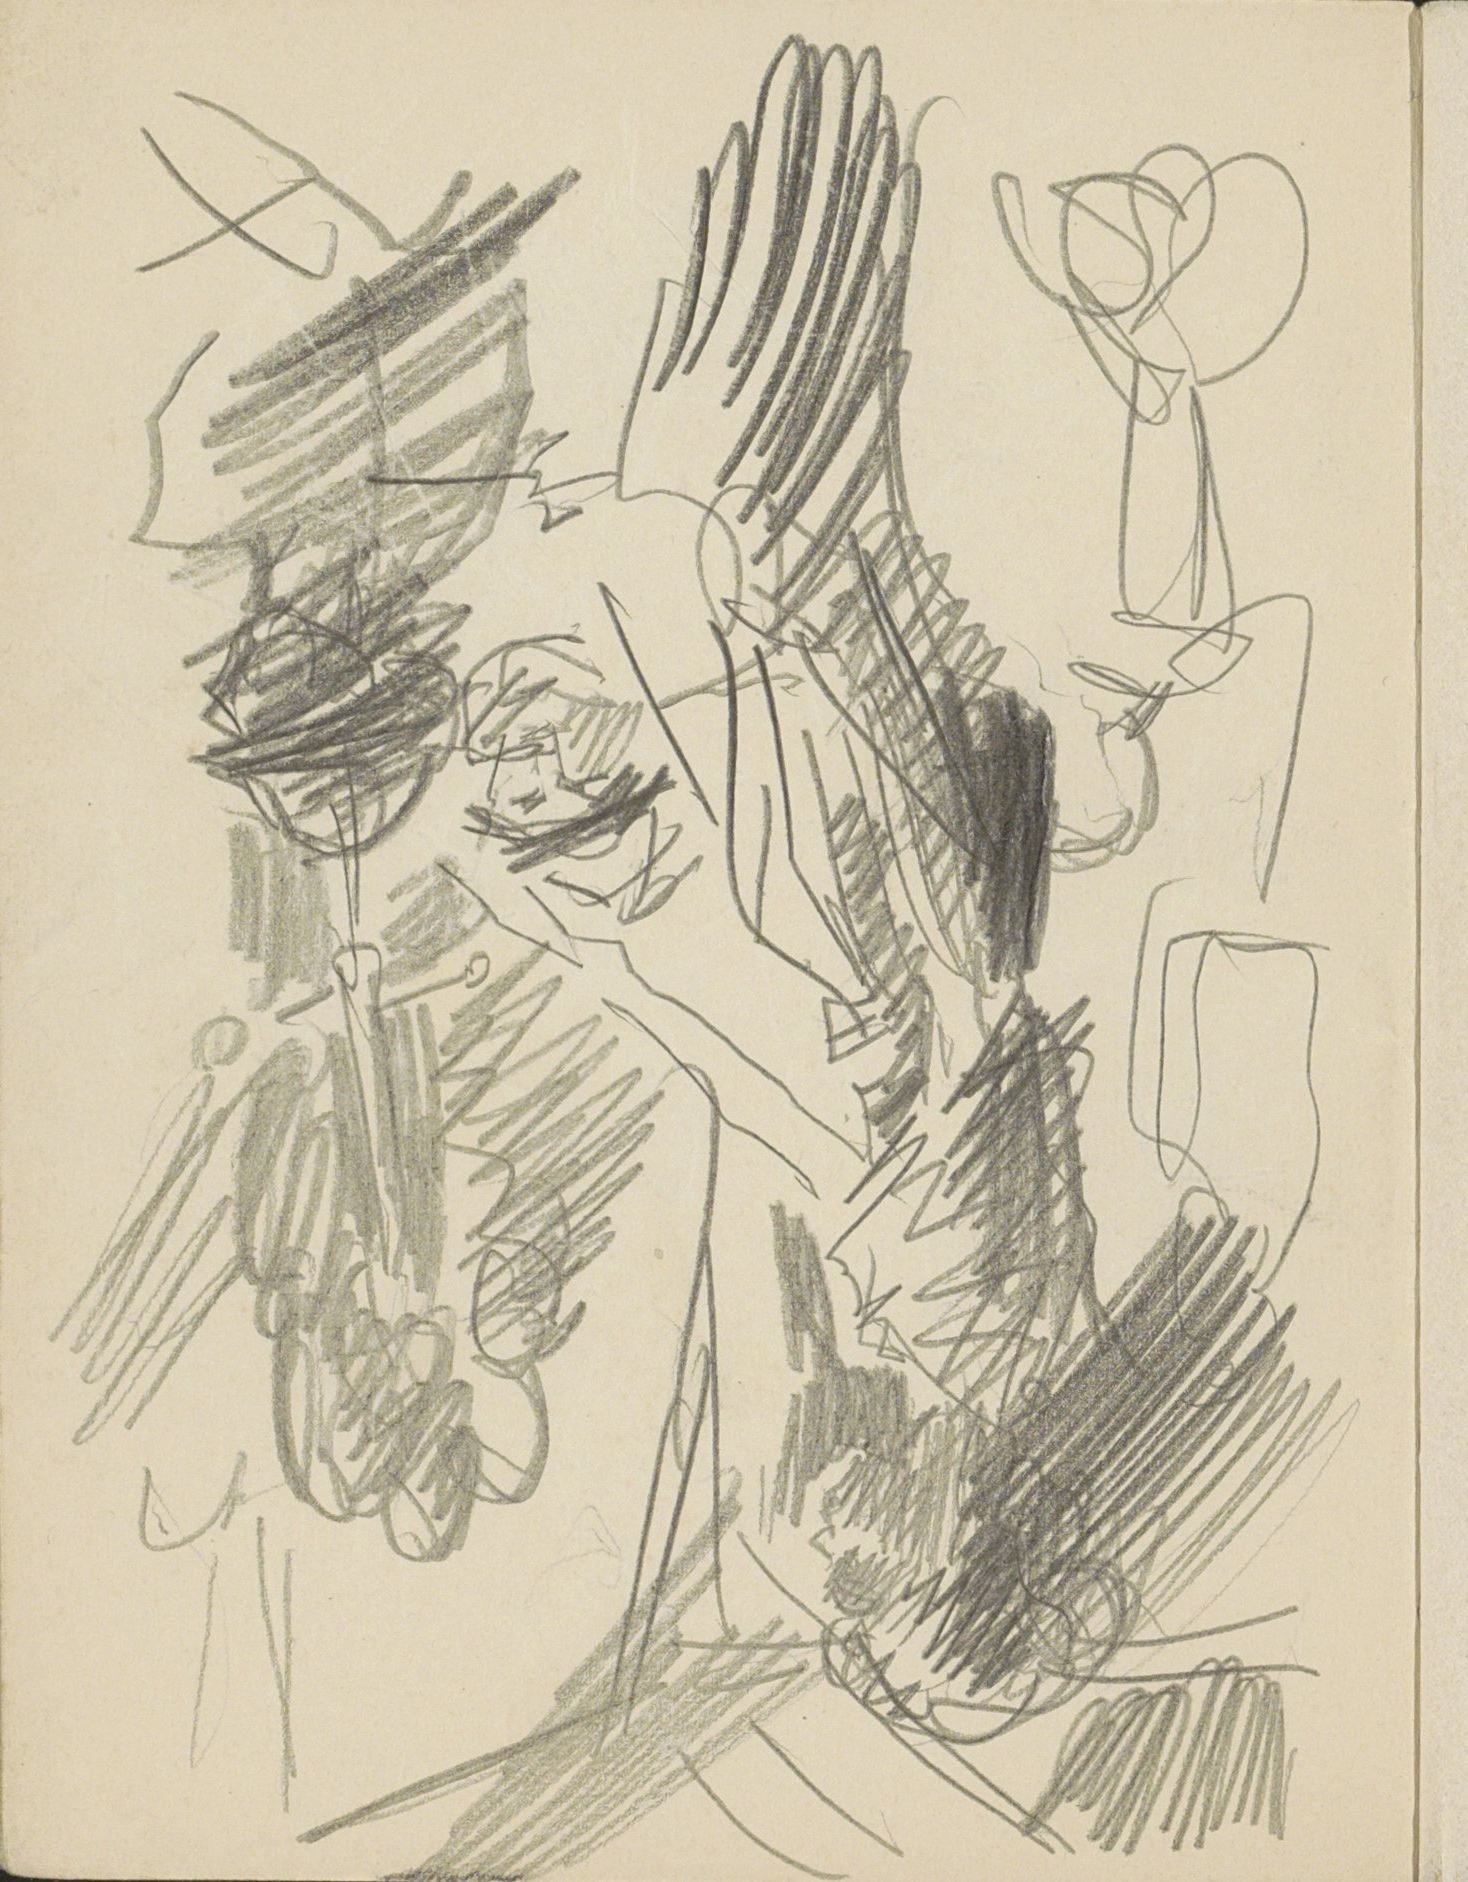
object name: sketchbook leaf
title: Zittende en staande Indische figuren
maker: isaac israels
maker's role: draughtsman, painter, print maker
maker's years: 1865-1934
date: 1921-1922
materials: paper, pencil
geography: dutch east indies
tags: asiatic races and peoples, adult man (+ sitting), adult woman (+ standing), dutch east indies, the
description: Pagina 6 uit schetsboek XXXIV met 24 pagina's.